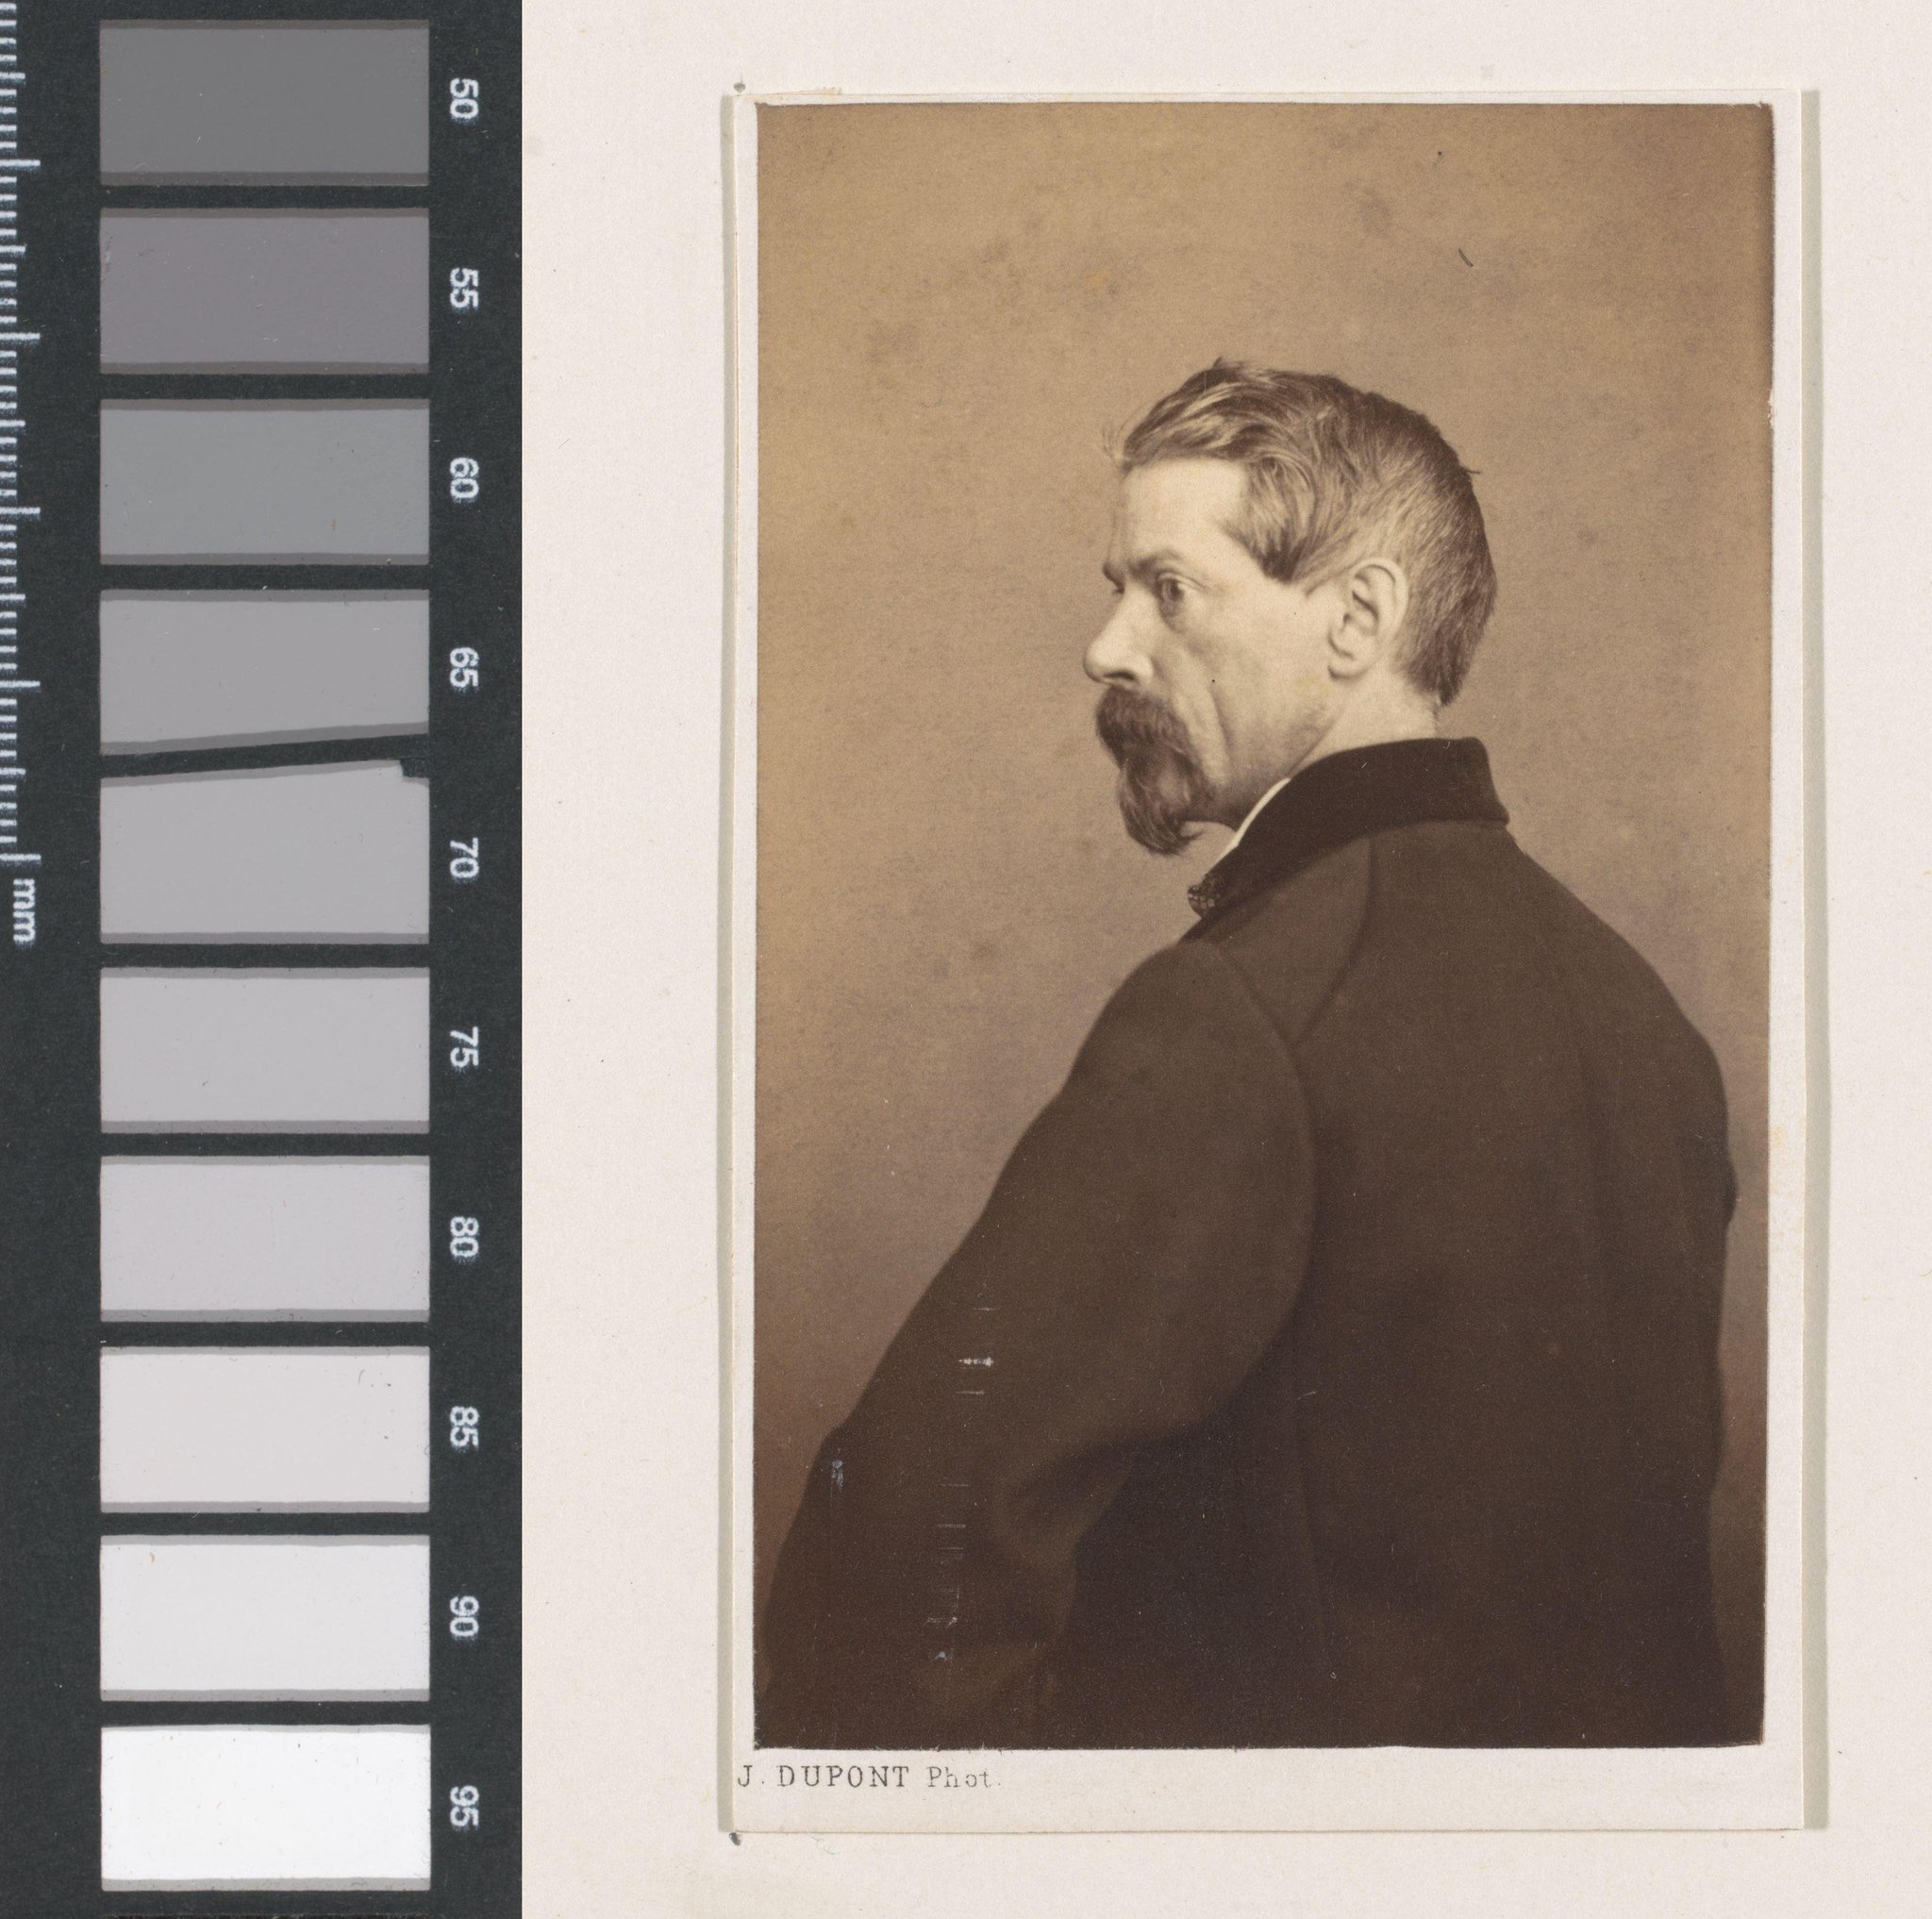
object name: photograph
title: L'École d'Anvers. Portraits biographies cartes de visite. Collection Dupont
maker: joseph dupont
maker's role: fotograaf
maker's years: 1818-1901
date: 1861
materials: cardboard, paper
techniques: albumen print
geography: antwerp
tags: portrait, self-portrait of sculptor, historical persons, portrait, self-portrait of artist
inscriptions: inscription: ‘ETABLISSEMENT PHOTOGRAPHIQUE/ de/ J. DUPONT/ Place de Meir 32/ ANVERS/ Maison fondée en 1853’